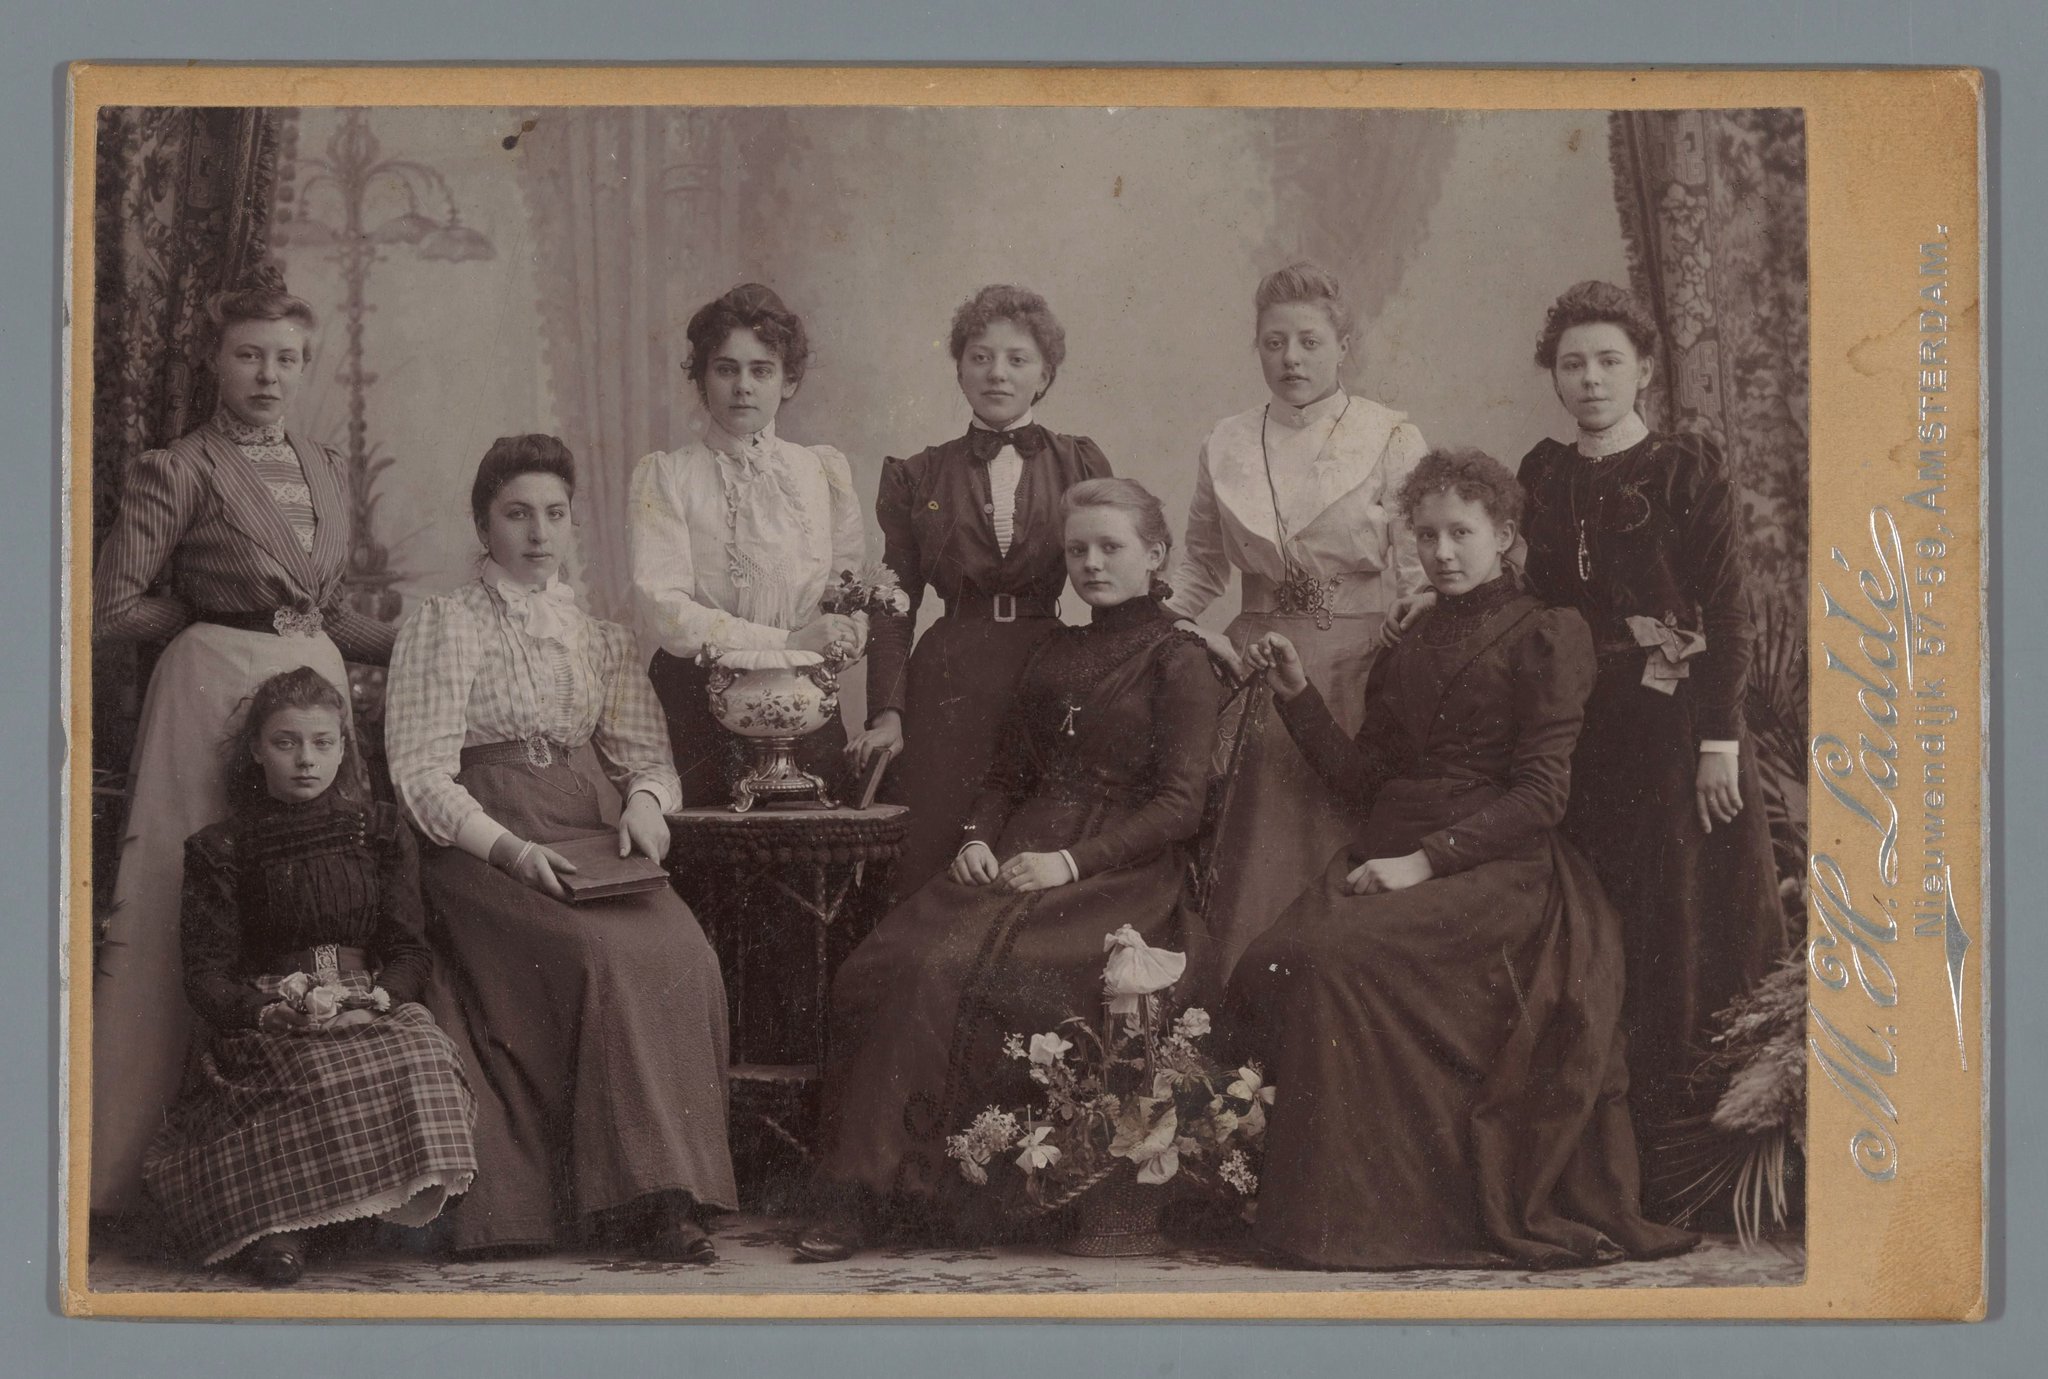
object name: cabinet photograph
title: Groepsportret van negen onbekende vrouwen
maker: machiel hendricus laddé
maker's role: fotograaf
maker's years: 1866-1932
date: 1892-1906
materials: cardboard, photographic support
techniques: collodion silver print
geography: amsterdam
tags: adult woman, studio requisites ~ photographer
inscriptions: name: ‘Fotografie Artistique M.H. Laddé boven de Firma Merkelbach & Co Amsterdam 57-59 Nieuwendijk (...)’